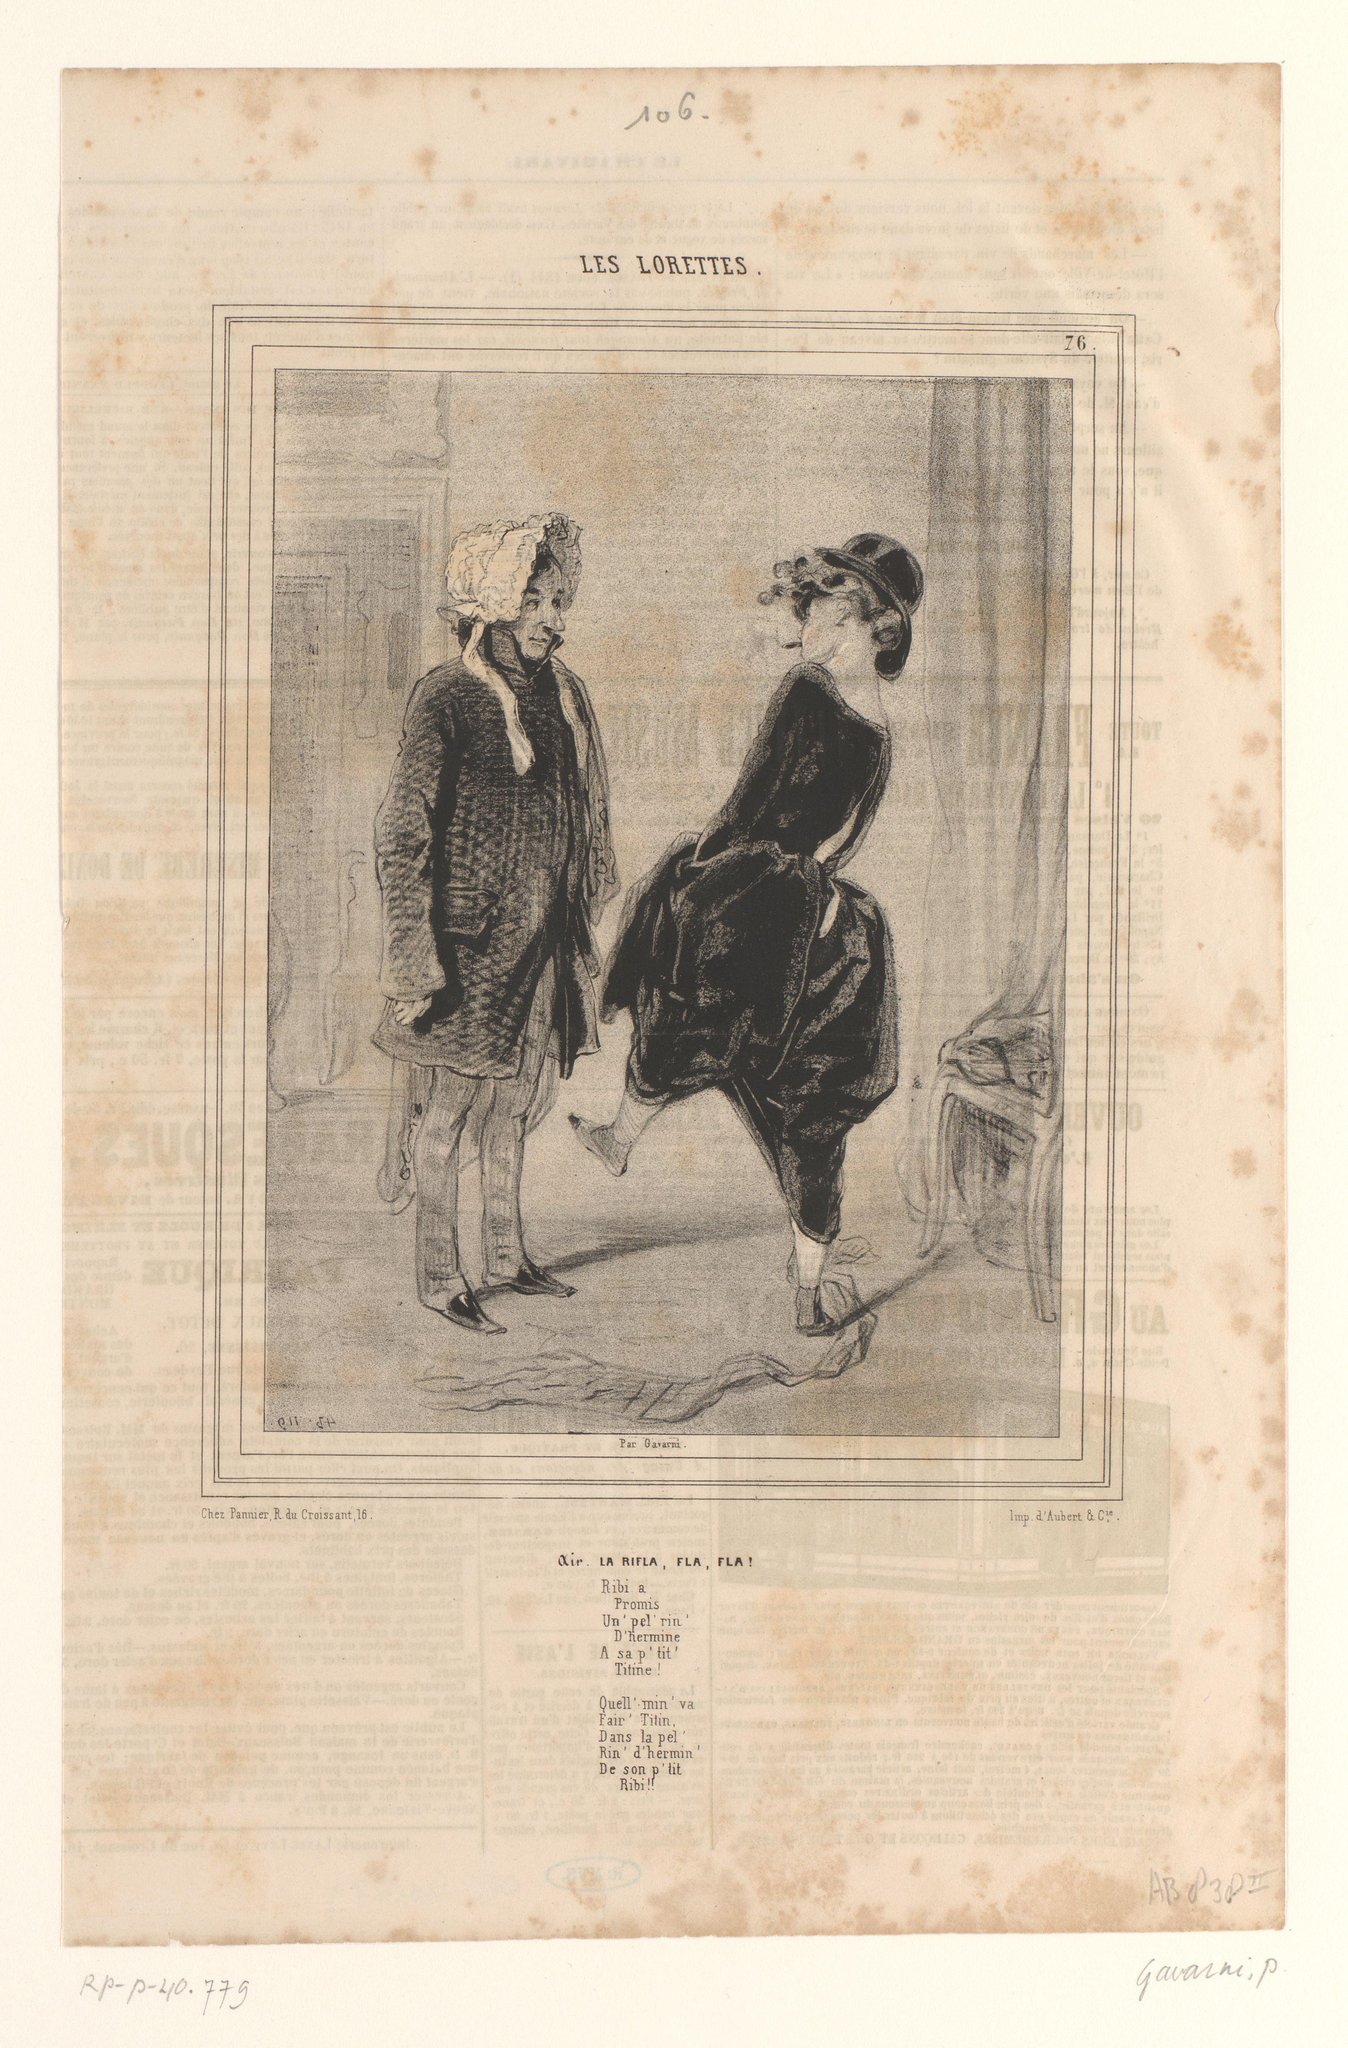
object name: cartoon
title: Vrouwen uit Notre-Dame-de-Lorette in Parijs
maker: paul gavarni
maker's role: draughtsman, print maker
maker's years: 1804-1866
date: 1843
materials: paper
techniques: lithograph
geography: paris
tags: woman dressed as man, travesty, adolescent, young woman, maiden, man dressed as woman, travesty, dress-up party, one person dancing alone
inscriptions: collector's mark: Lugt 2228a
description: Prent gebruikt voor: Le Charivari, 21 oktober 1843.